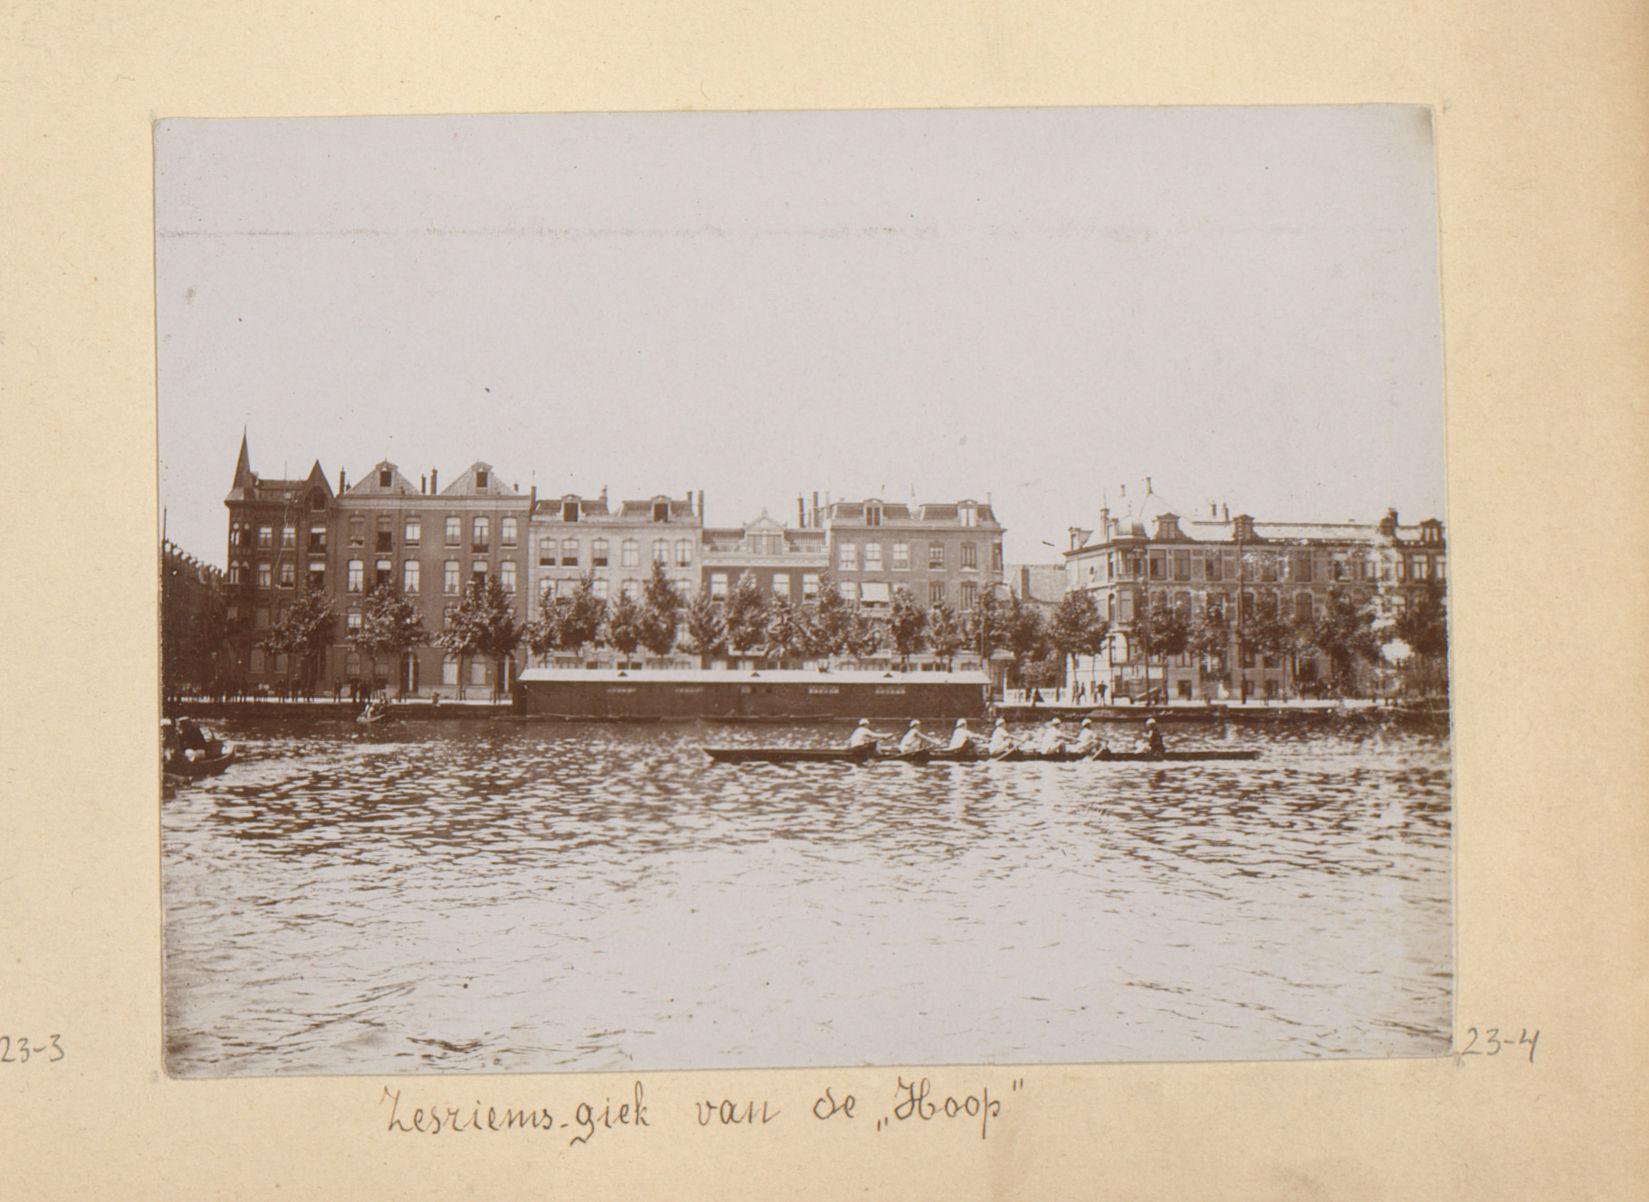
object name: album leaf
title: Zesriems giek van de "Hoop"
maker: hendrik herman van den berg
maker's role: amateurfotograaf, jurist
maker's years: 1875-1944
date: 1890-1894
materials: paper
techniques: collodion silver print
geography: amsterdam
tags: urban housing, rowing facing backward, pulling, canals, waters (in city)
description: Foto 4 op albumblad 23 uit album "Amsterdam 1890-1894".